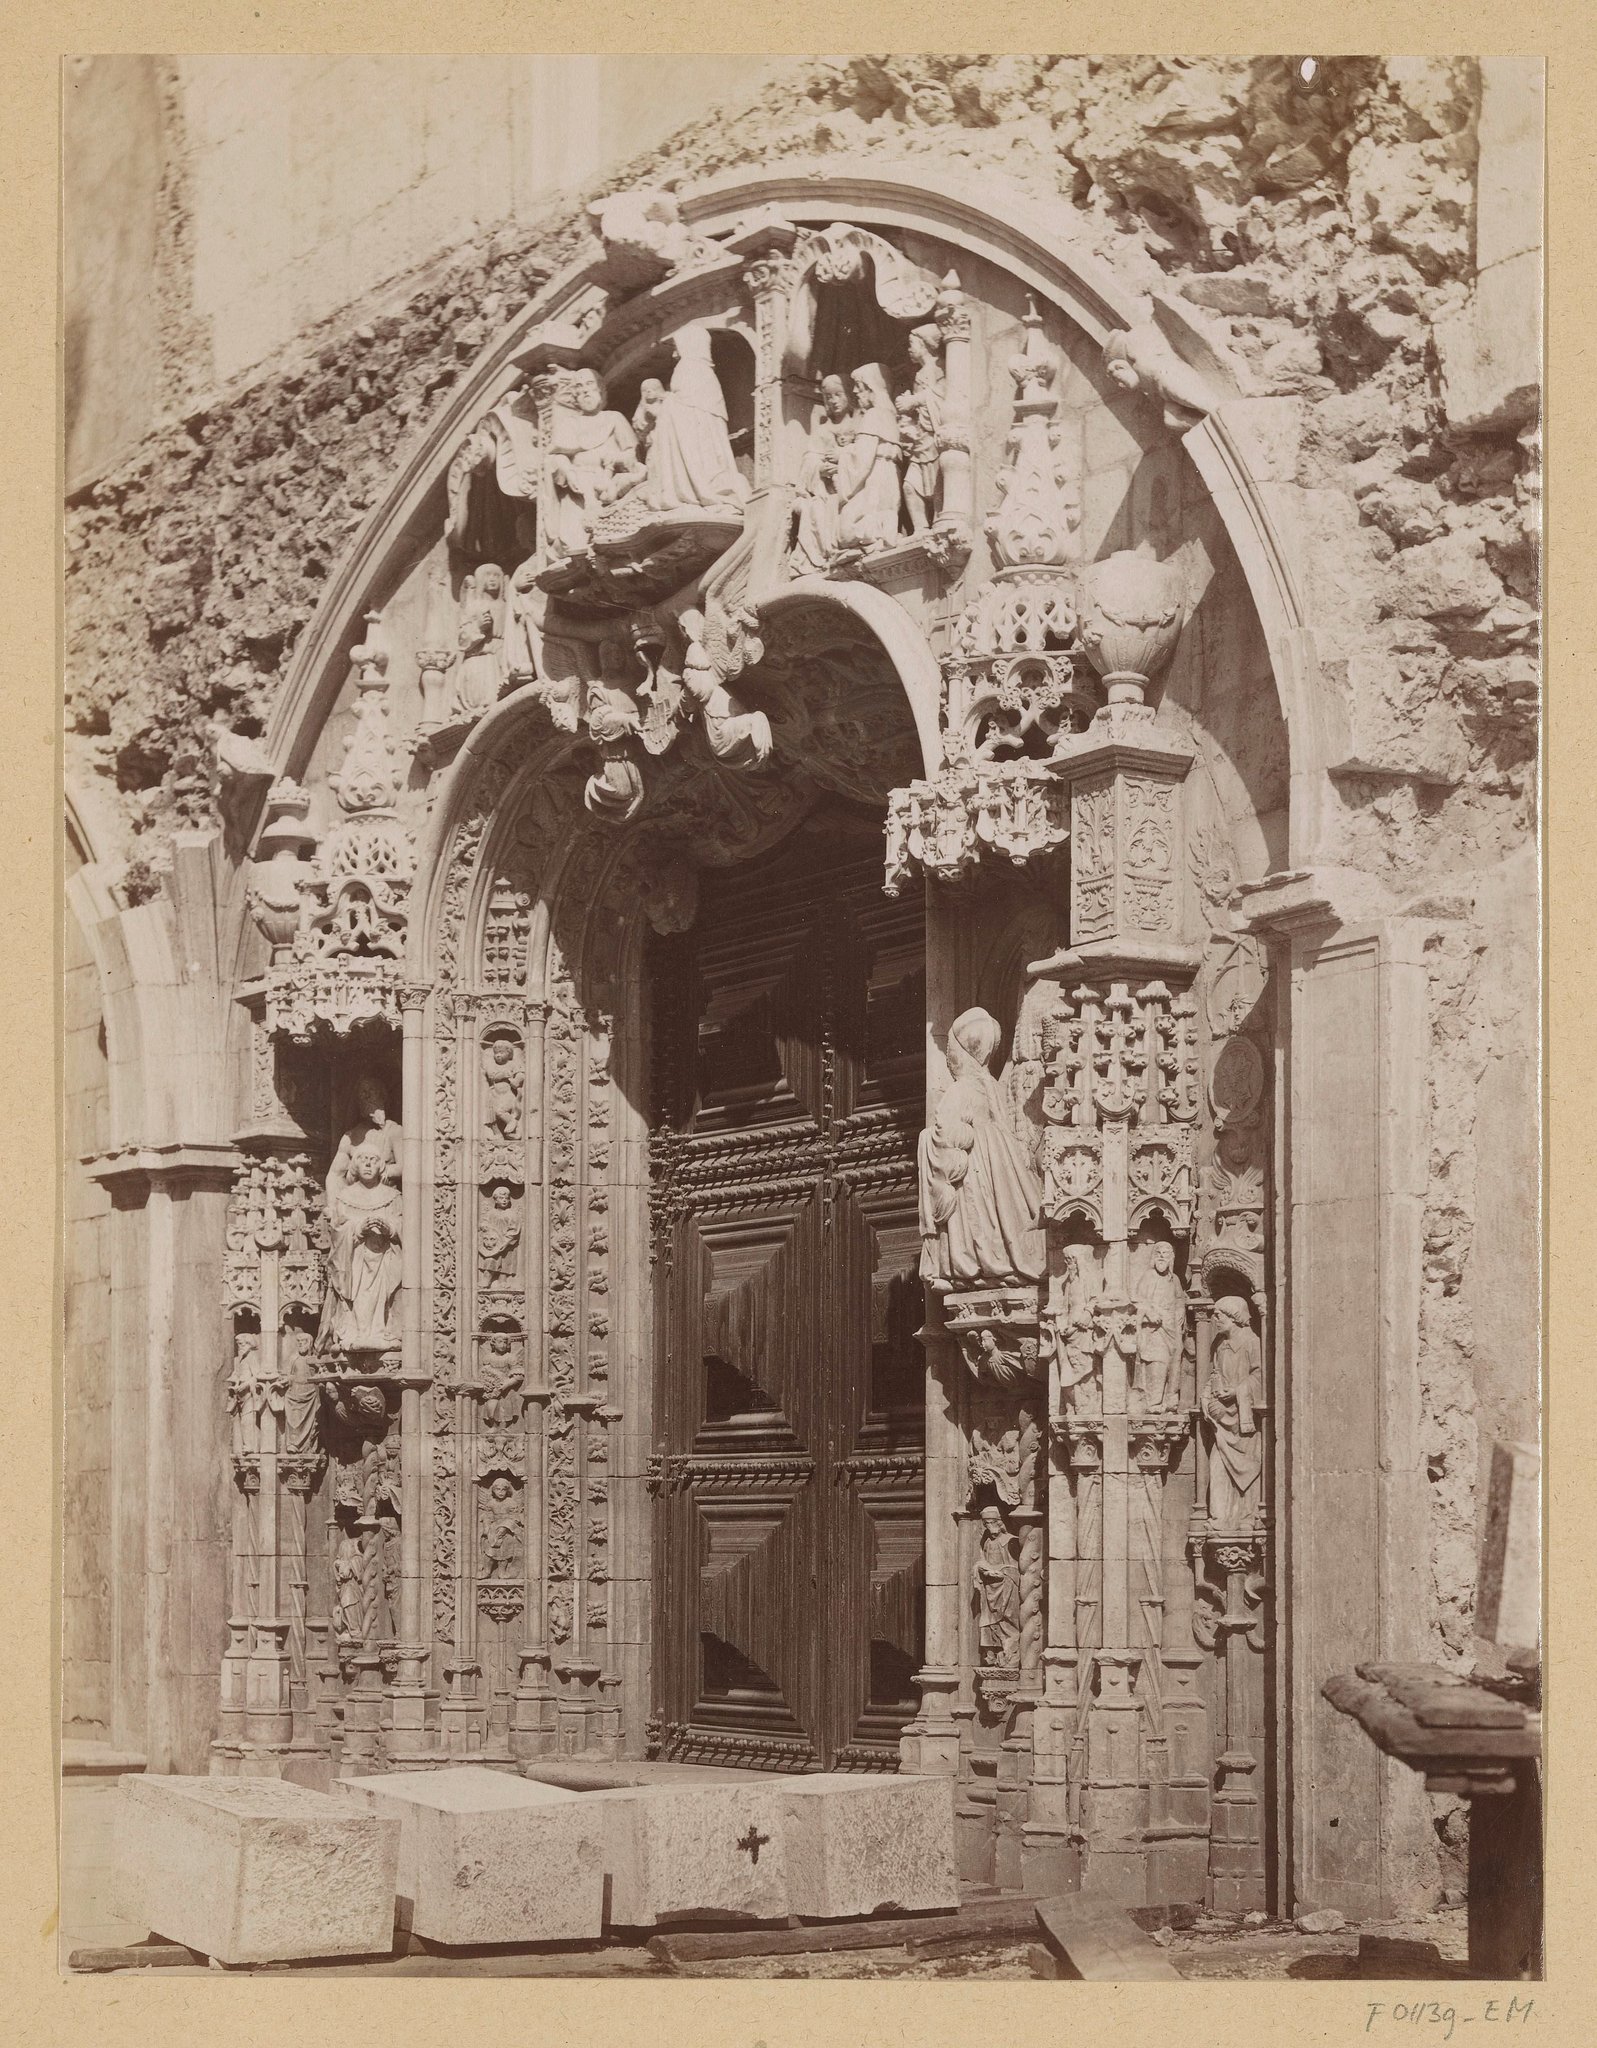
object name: photograph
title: Westportaal van het Mosteiro dos Jerónimos in Lissabon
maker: Anonymous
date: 1851-1890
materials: paper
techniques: albumen print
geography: lisbon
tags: parts of church exterior and annexes: portal